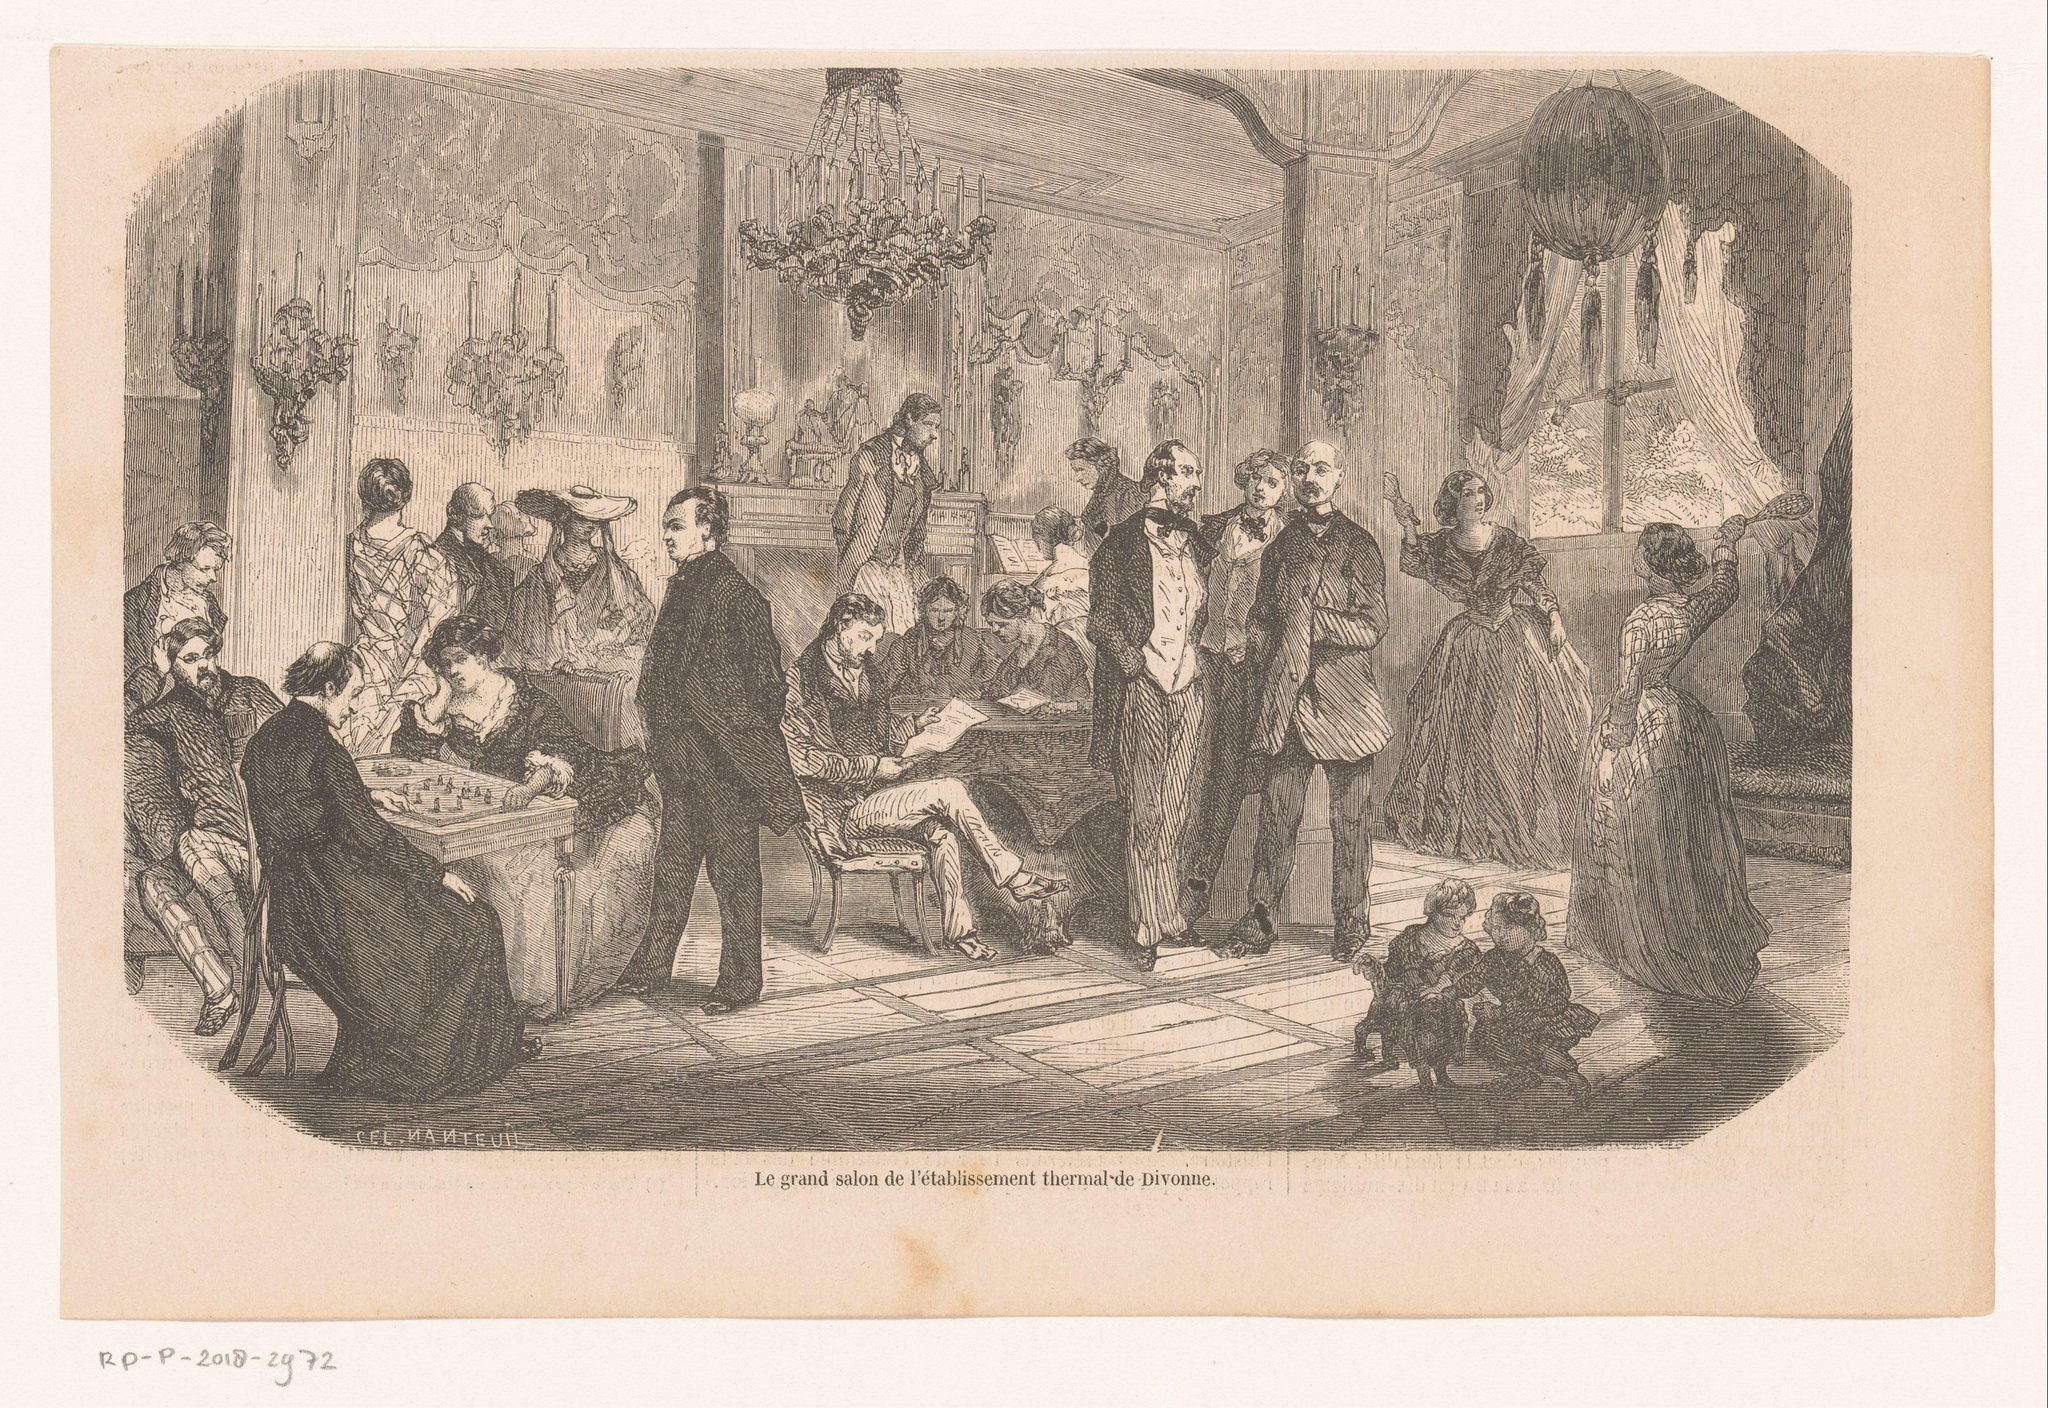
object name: print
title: Le grand salon de l'établissement thermal de Divonne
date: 1856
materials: paper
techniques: letterpress printing, engraving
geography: paris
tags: interior of the house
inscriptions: date: ‘L'Illustration 19 juli, 1856’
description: Prent uit: L'Illustration, Journal Universel, 19 juli 1856.